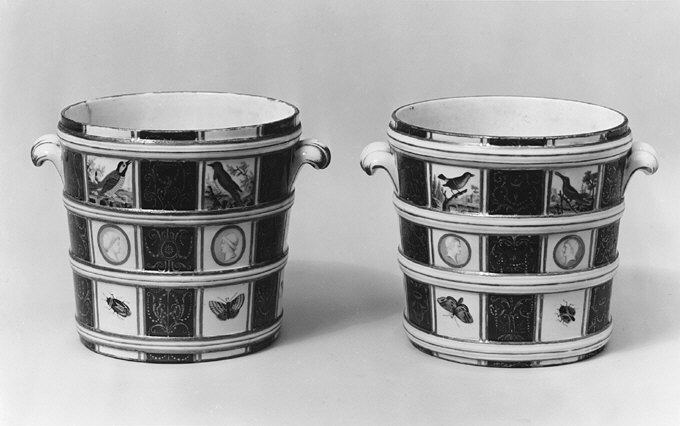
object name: glass cooler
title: Pair of glass coolers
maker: tournai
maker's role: factory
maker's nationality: belgian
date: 1787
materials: soft paste porcelain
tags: birds,profiles,insects,butterflies